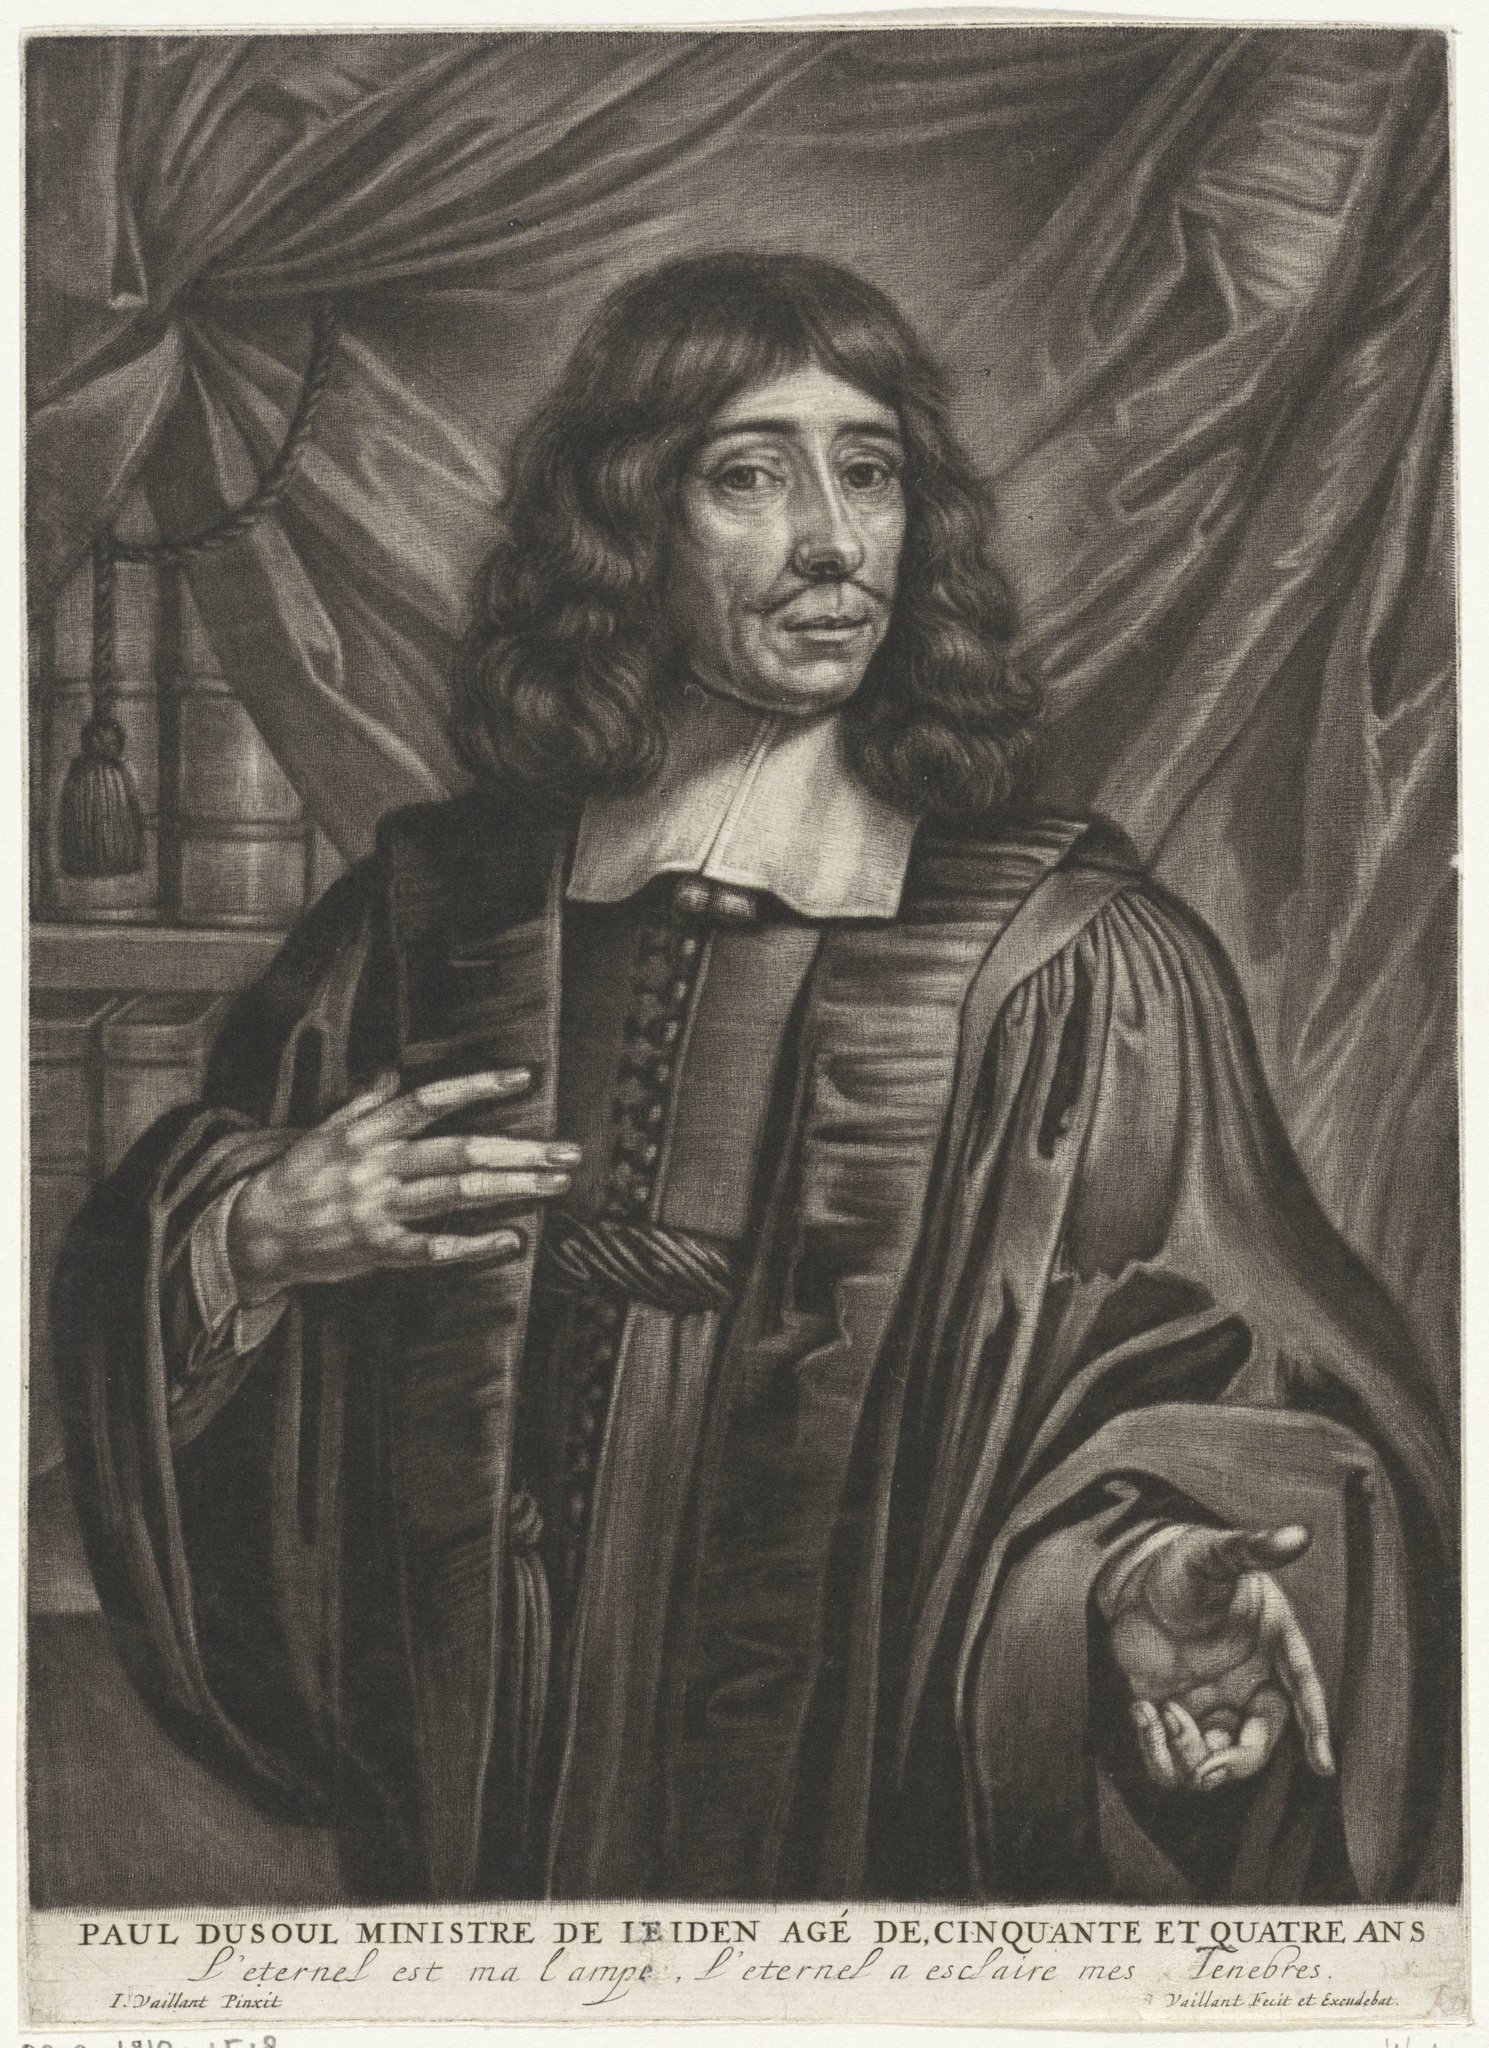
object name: print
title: Portret van Paul Dusoul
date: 1642-1698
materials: paper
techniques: engraving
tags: book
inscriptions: collector's mark: Lugt 2228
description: Paul Dusoul op 54-jarige leeftijd. Hij staat voor een boekenkast en een gordijn.